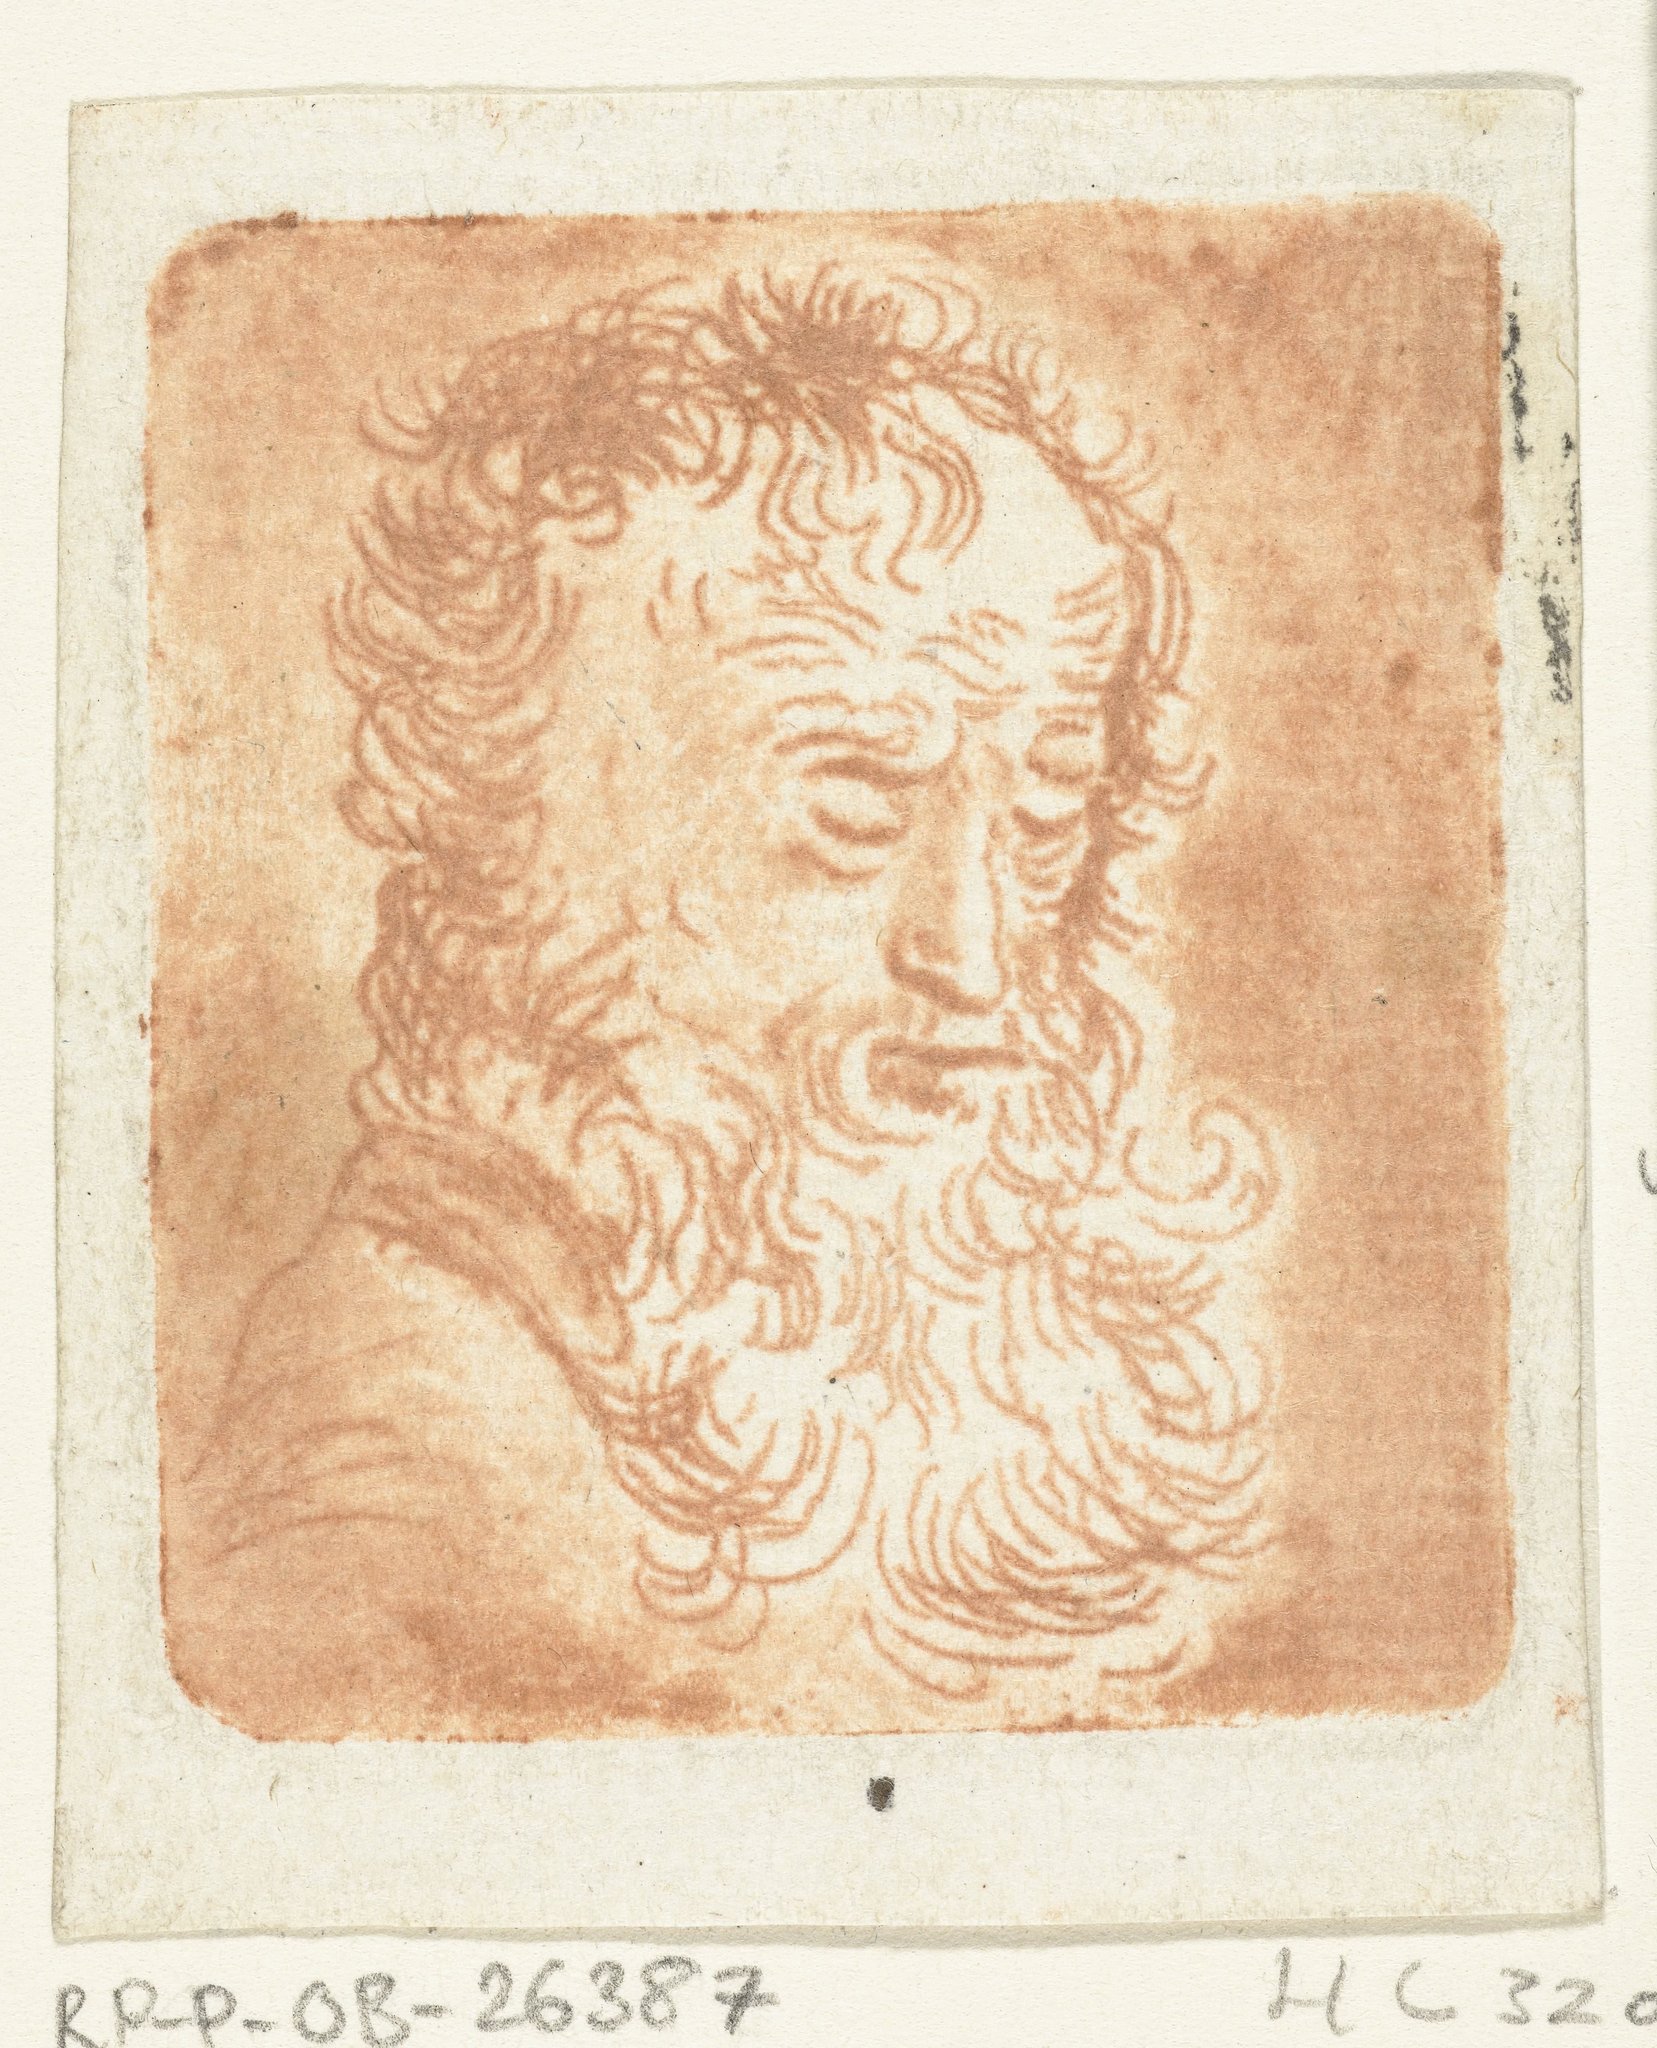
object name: print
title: Oude man met baard met de blik naar beneden gericht: driekwart, naar rechts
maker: ernst willem jan bagelaar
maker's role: draughtsman, print maker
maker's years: 1775-1837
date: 1798-1837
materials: paper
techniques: etching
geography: netherlands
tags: old man